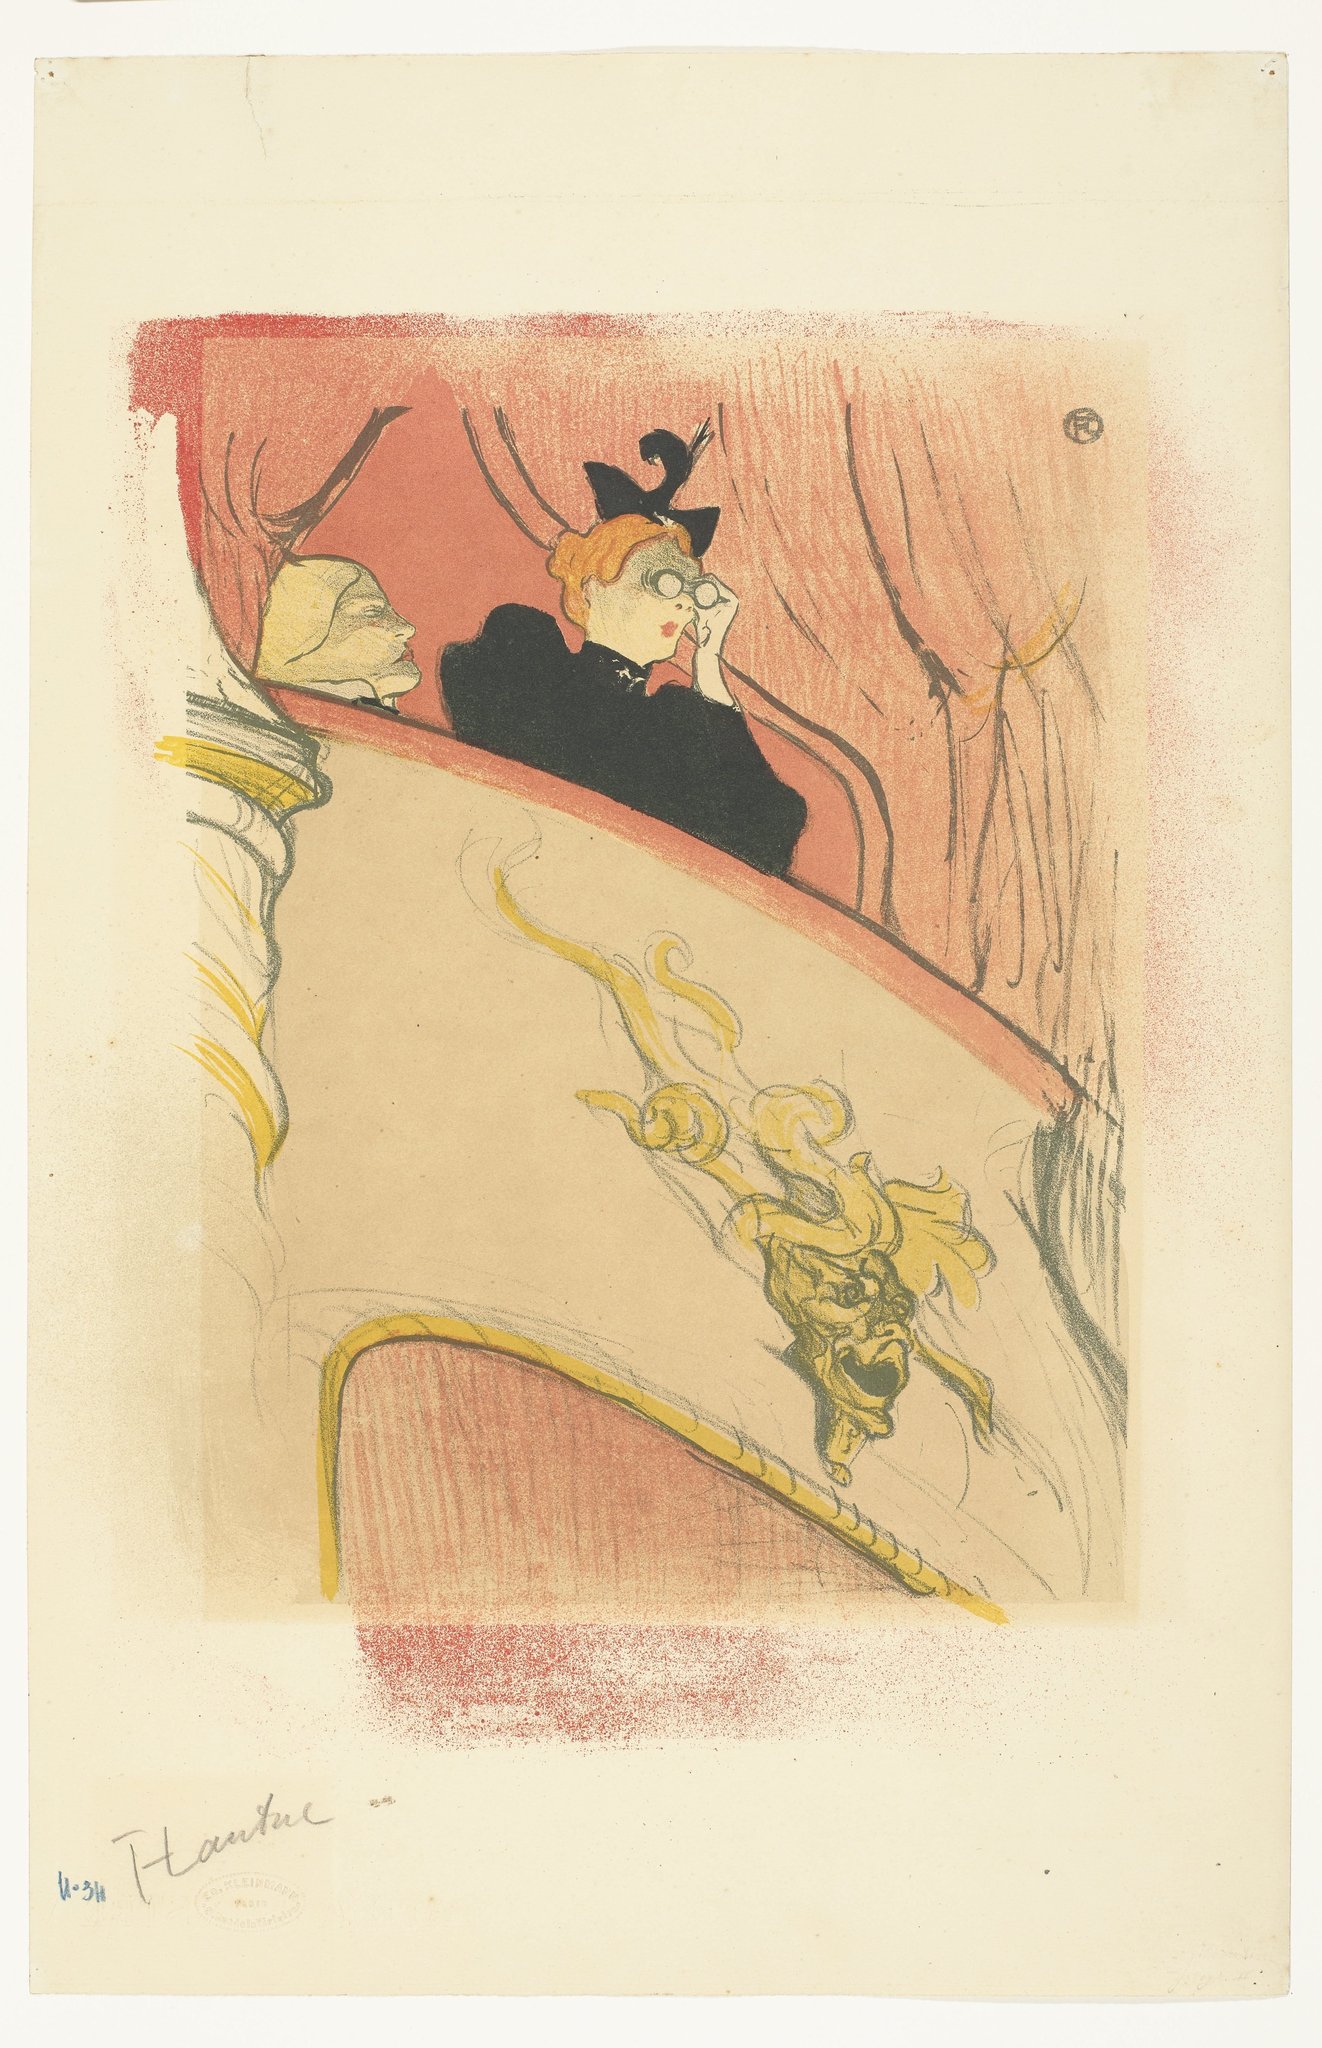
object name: print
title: ‘La Loge au Mascaron doré’ (The Box with the Gilded Mask)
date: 1894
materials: paper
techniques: printing, lithograph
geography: paris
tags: female sex; woman, theatre (building), the audience ~ art performance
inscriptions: collector's mark: Lugt 2228, check stamp: Lugt 1573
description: The title of this print refers to the gilded mask on the balustrade of the theatre box. The woman’s companion is a friend of Lautrec, the English artist Charles Conder. The intriguing composition was inspired by the interplay of lines and the cropping in Japanese woodcuts. This lithograph was intended as the programme of a play and is a fine example of effective and sparing use of colour.